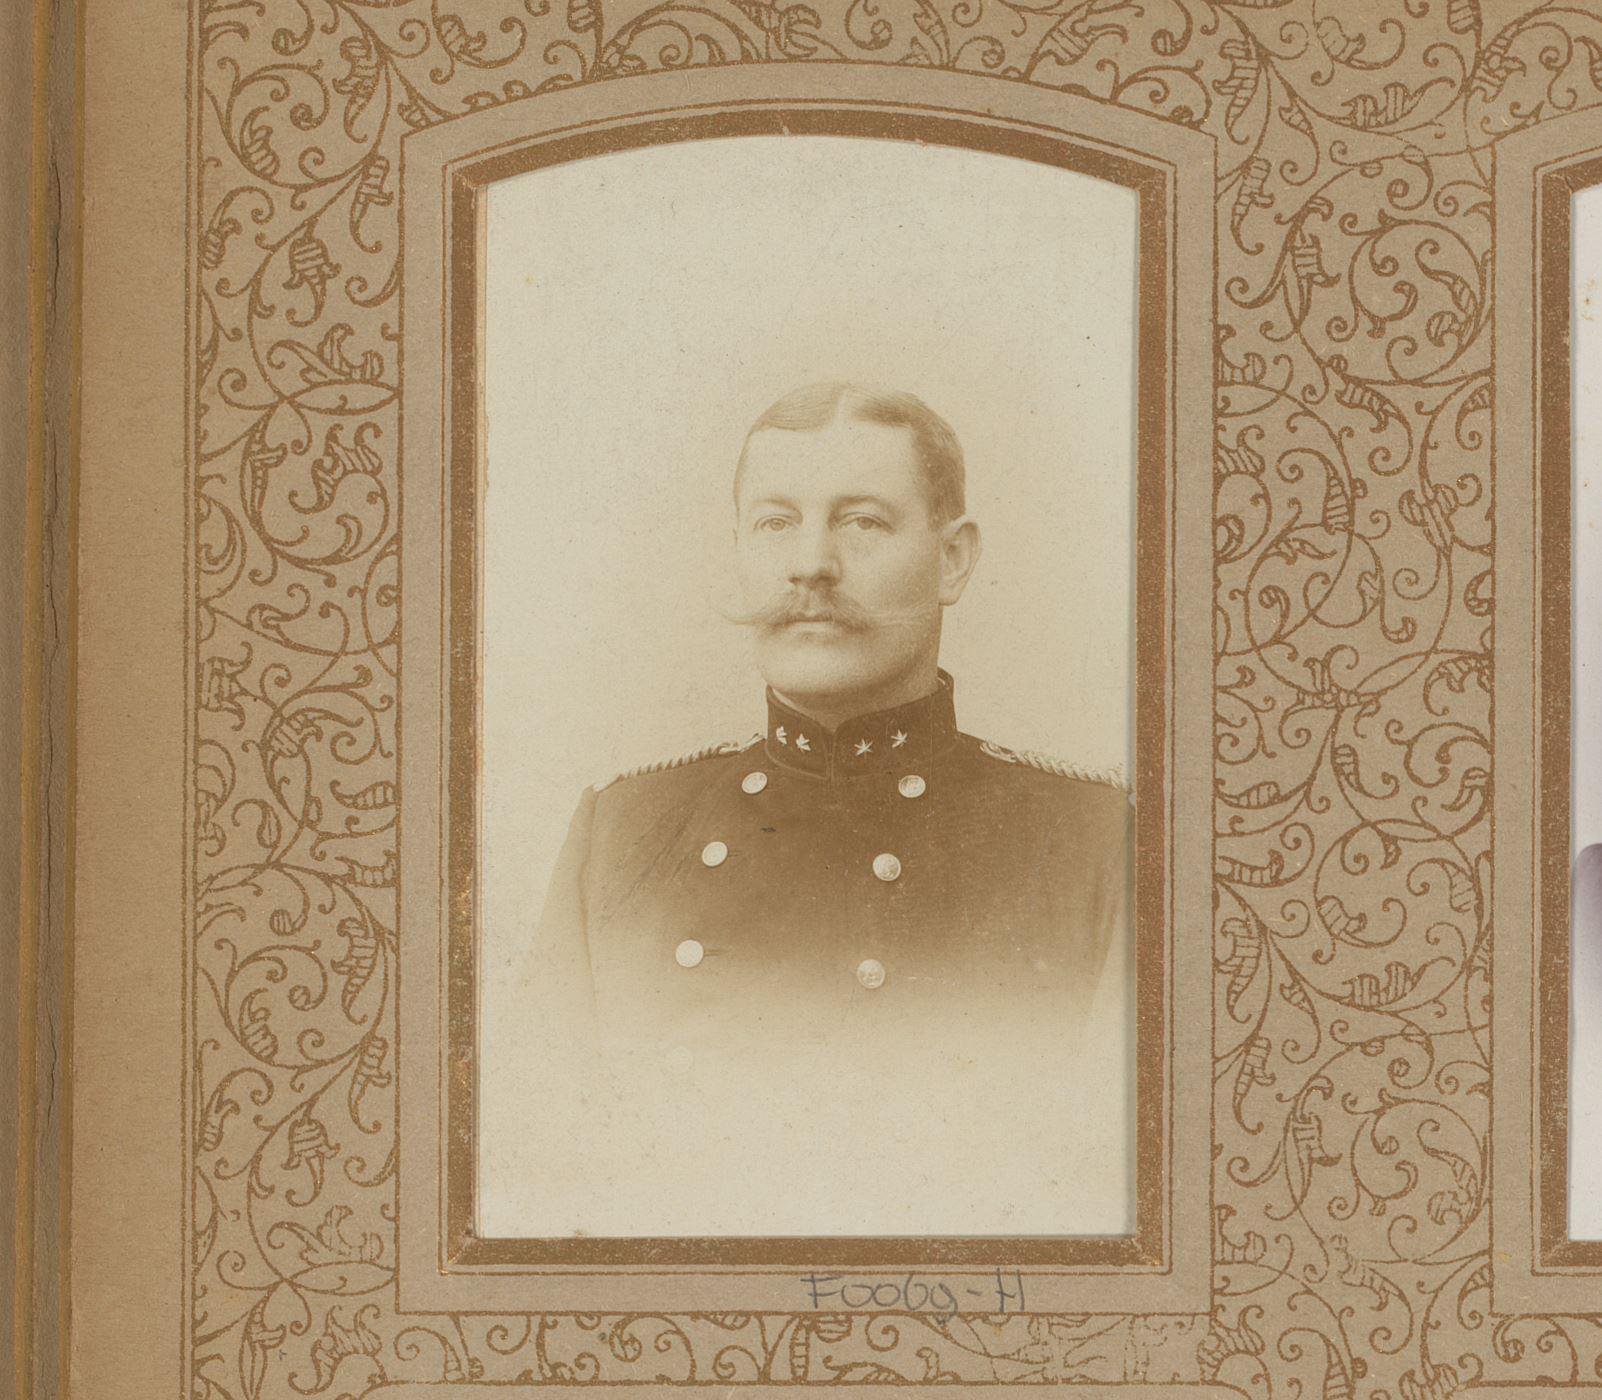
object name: album leaf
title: Portret van een man in uniform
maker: j.w. wentzel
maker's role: fotograaf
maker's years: 1855-1930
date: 1890-1898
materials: cardboard, photographic support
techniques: collodion silver print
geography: amersfoort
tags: historical persons, (military) uniforms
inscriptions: name: ‘[...]’, inscription: ‘J.W. Wentzel/ Amersfoort/ Langestraat F.12.’